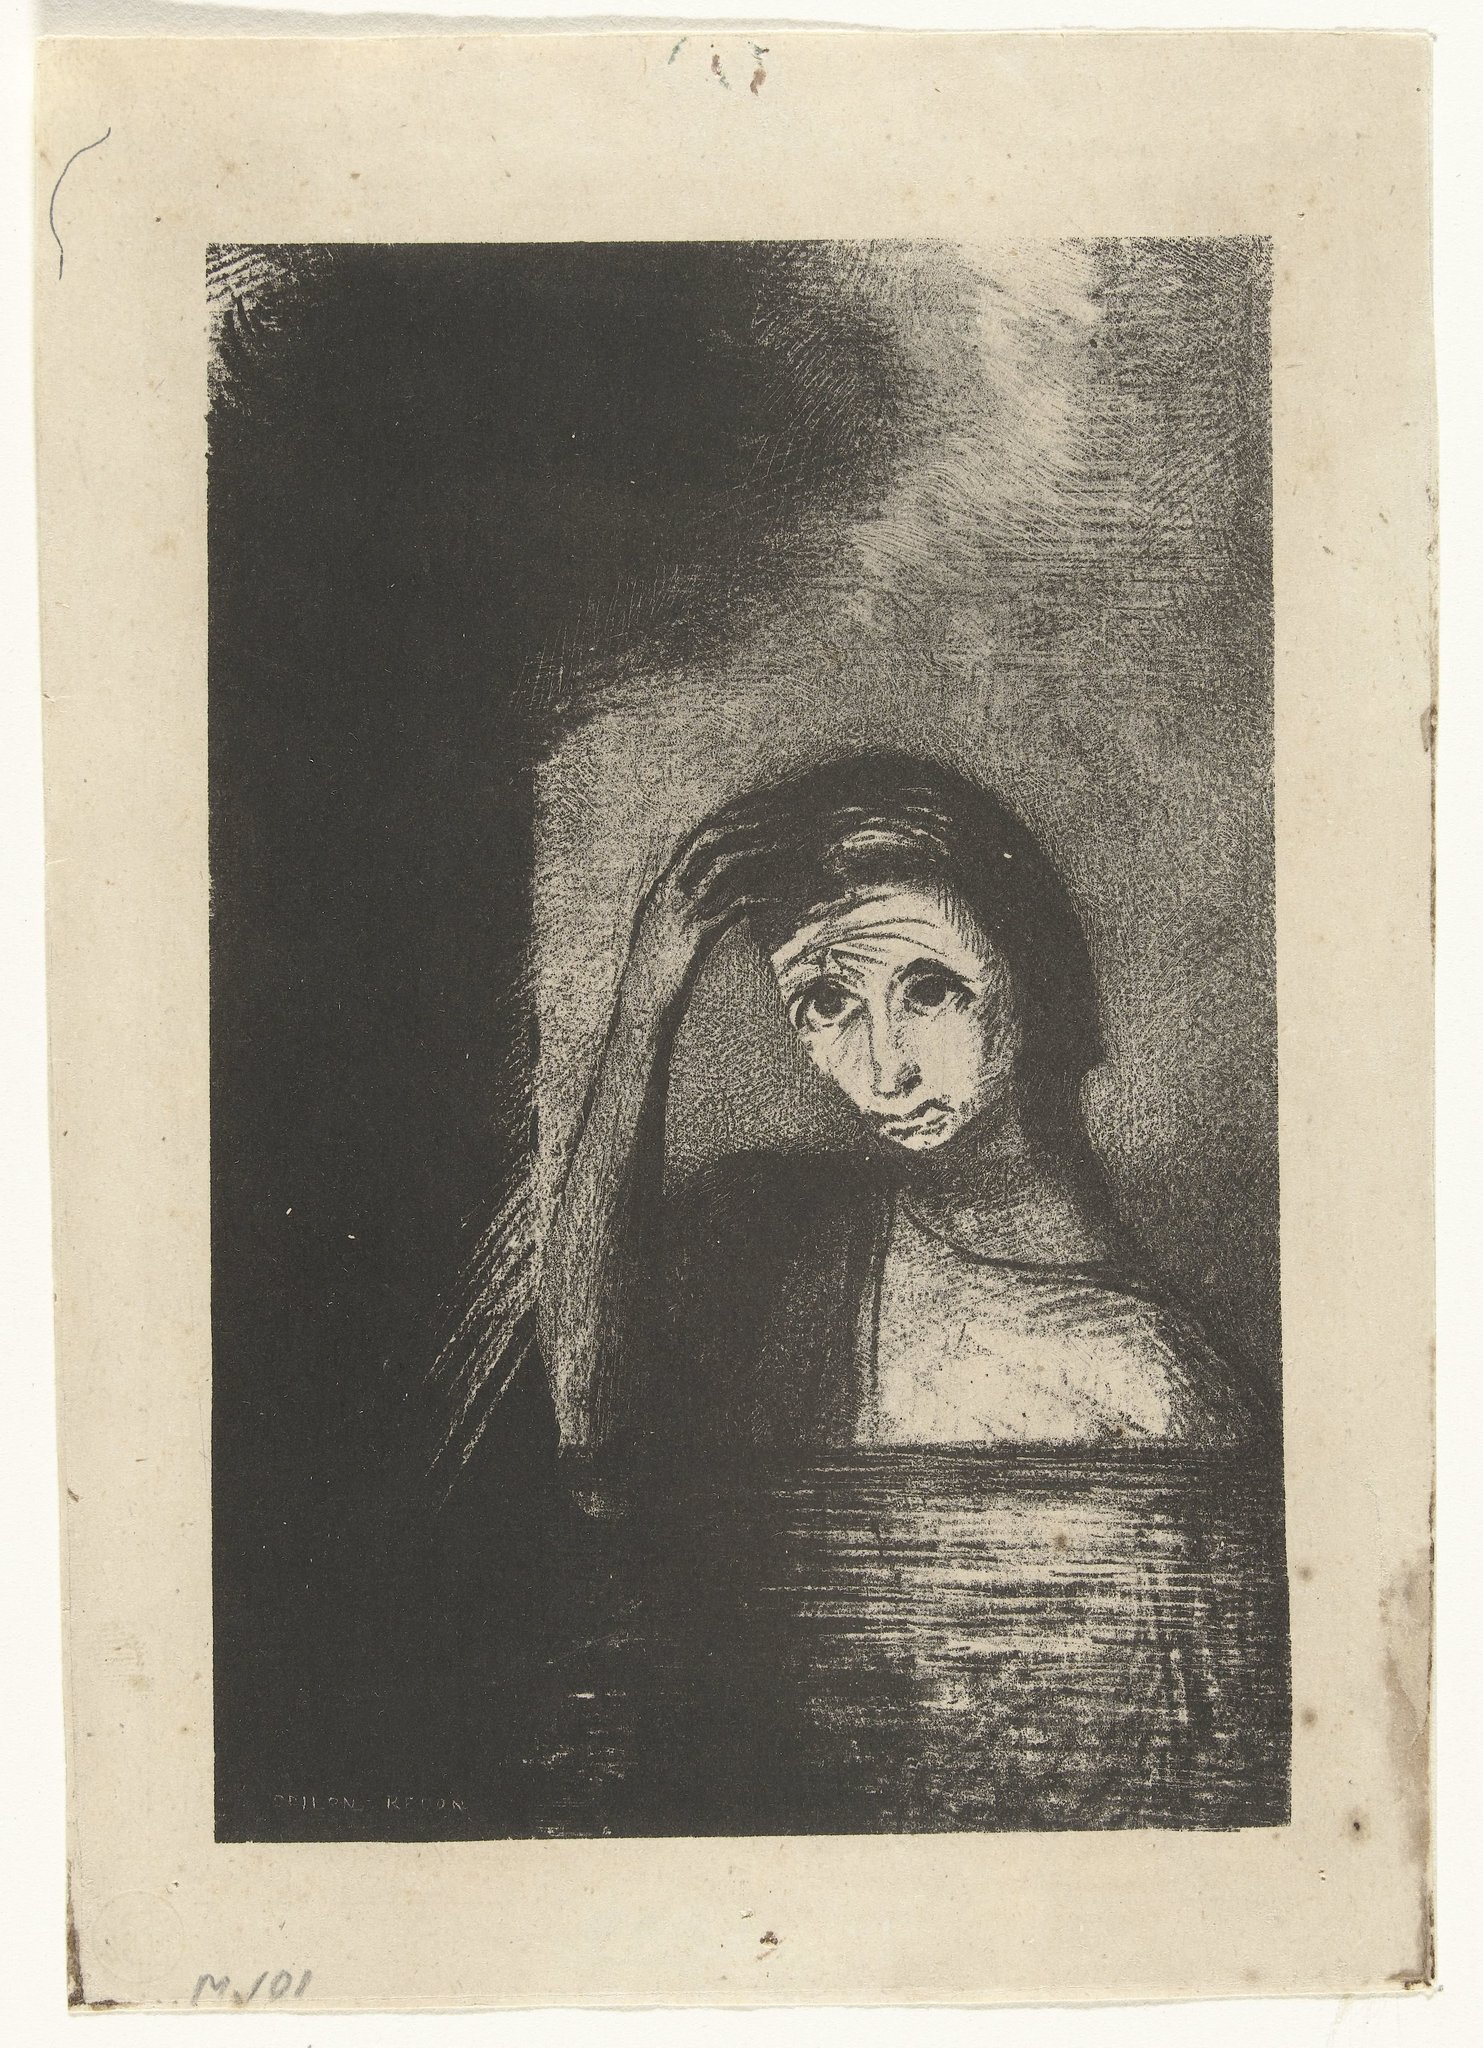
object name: print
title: Les Débâcles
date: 1889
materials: paper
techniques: lithograph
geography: paris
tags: adult man, hand(s) bent towards the head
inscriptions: collector's mark: ‘S’, collector's mark: Lugt 2228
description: Prent is gemaakt voor de titelpagina van Emile Verhaeren's "Les Debacles", uitgegeven in Brussel bij Deman in 1889.